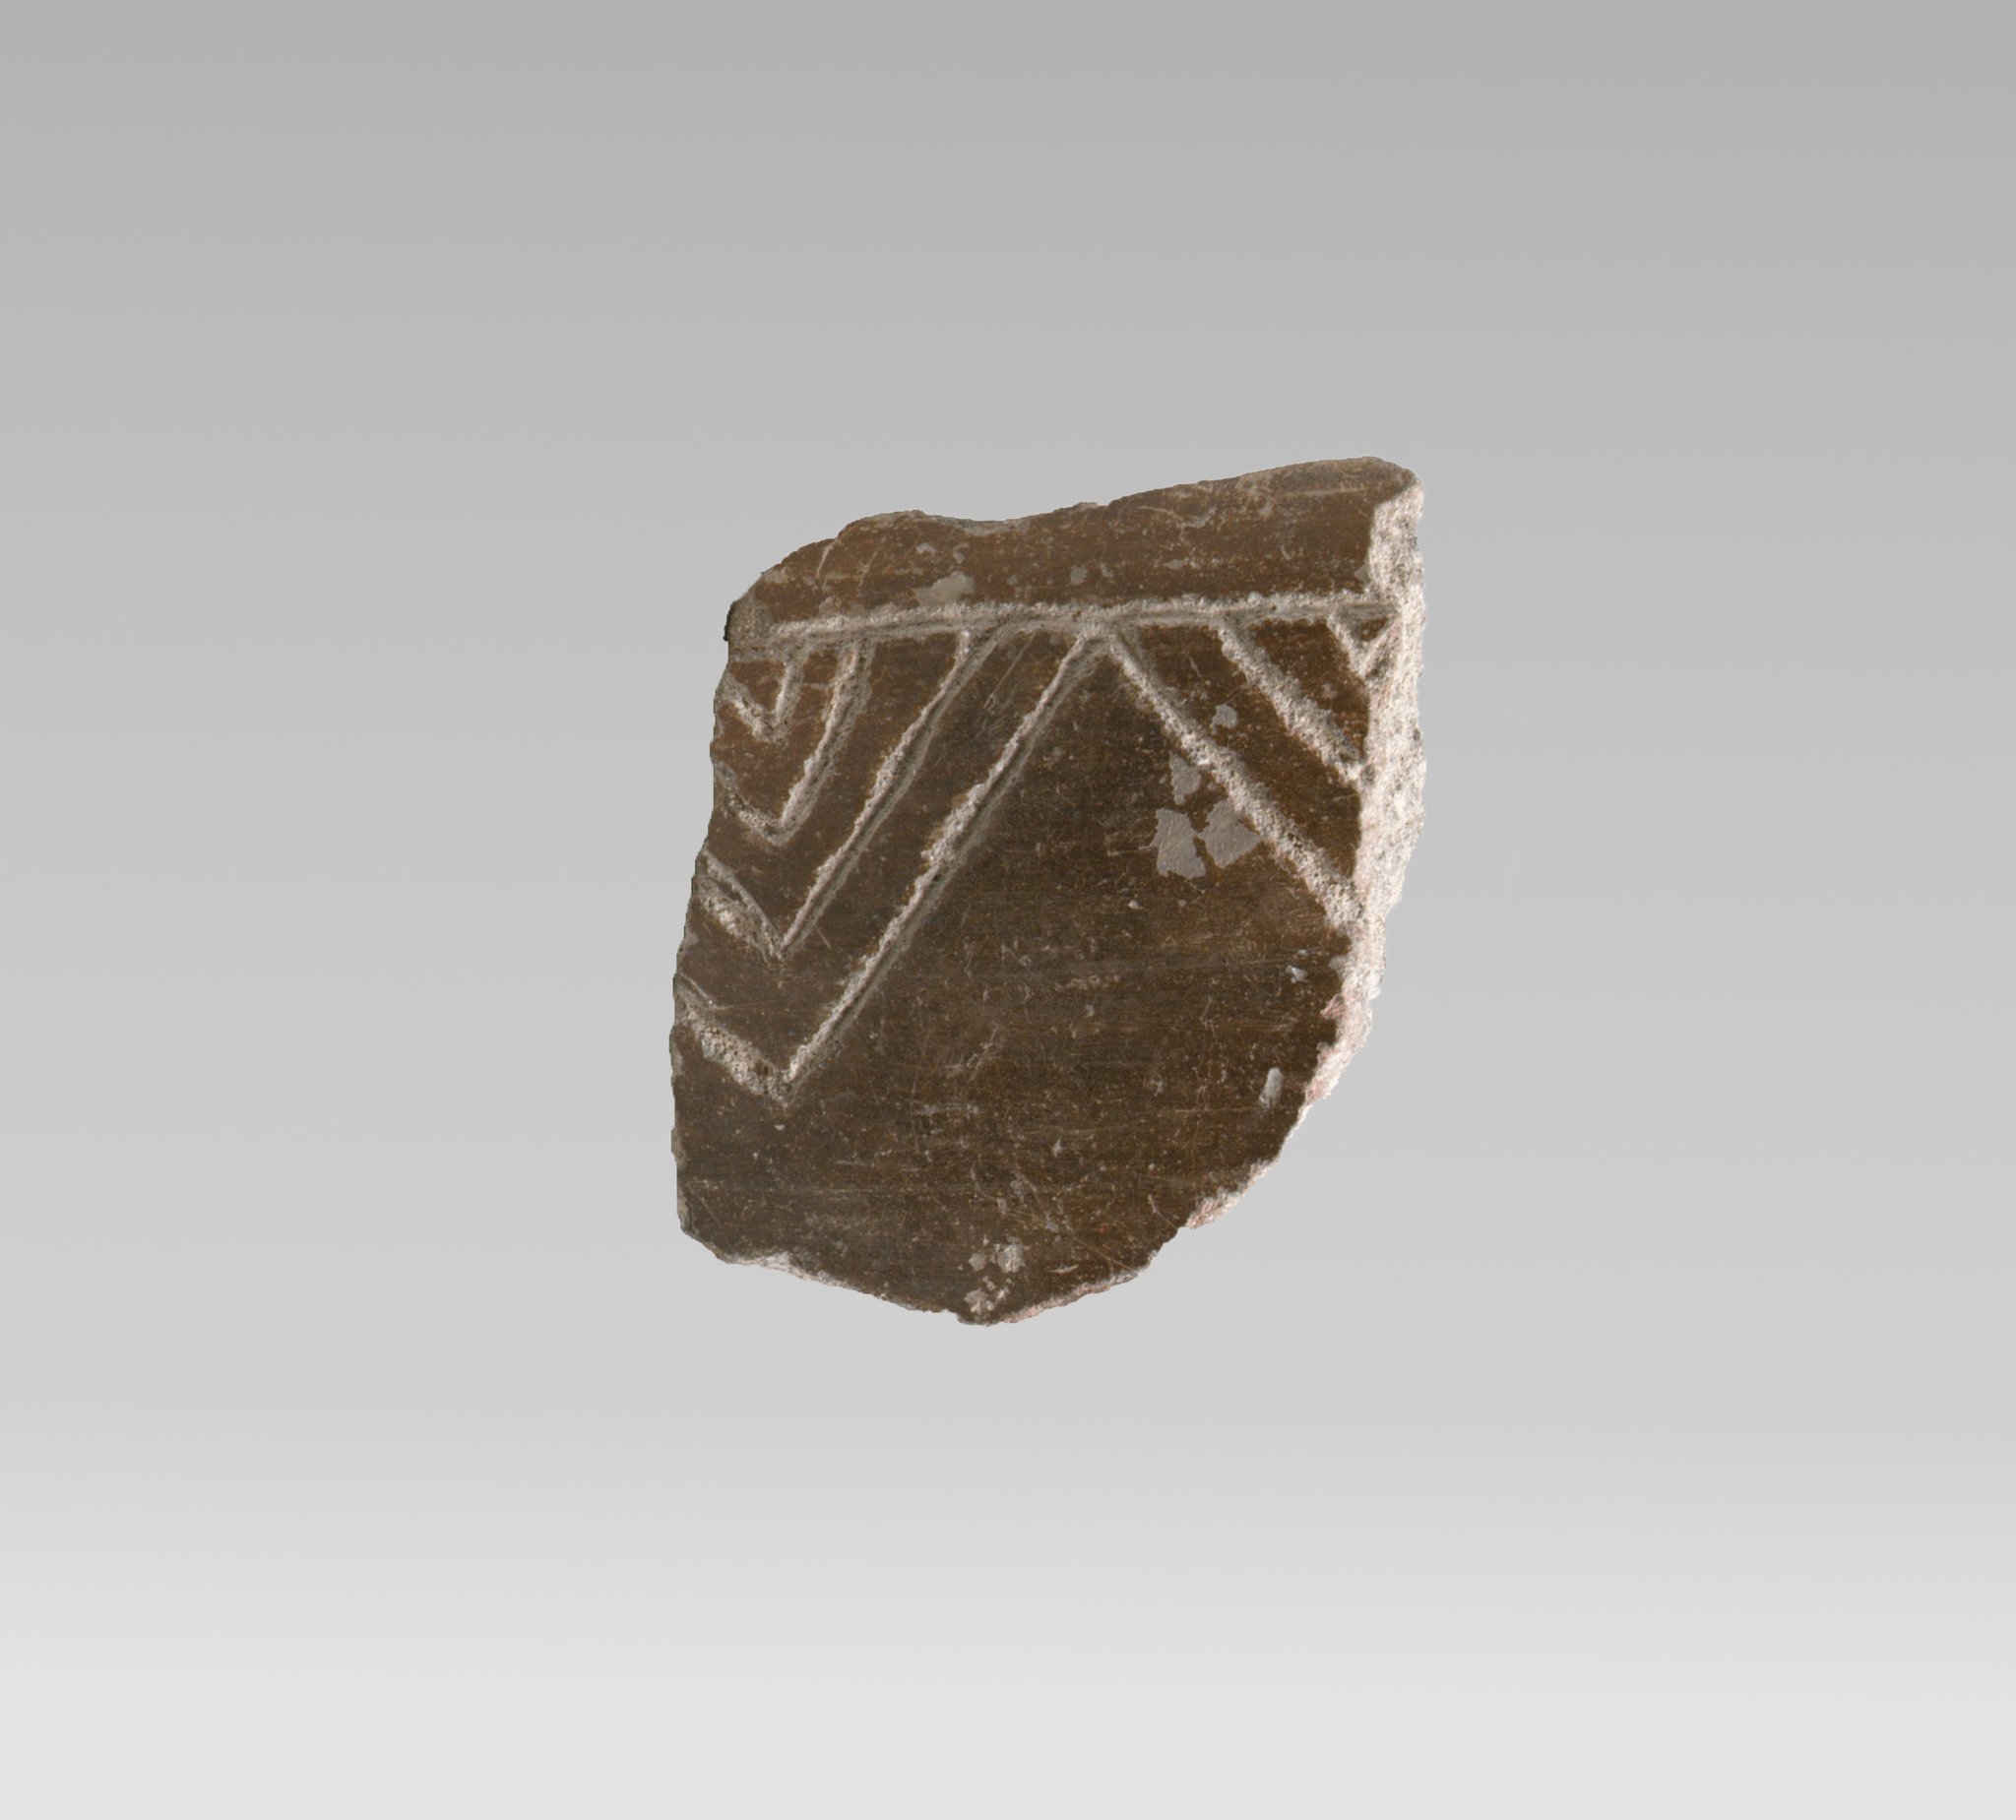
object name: vase fragment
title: Terracotta vessel fragment with incised decoration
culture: cretan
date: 3600-3100 BCE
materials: terracotta